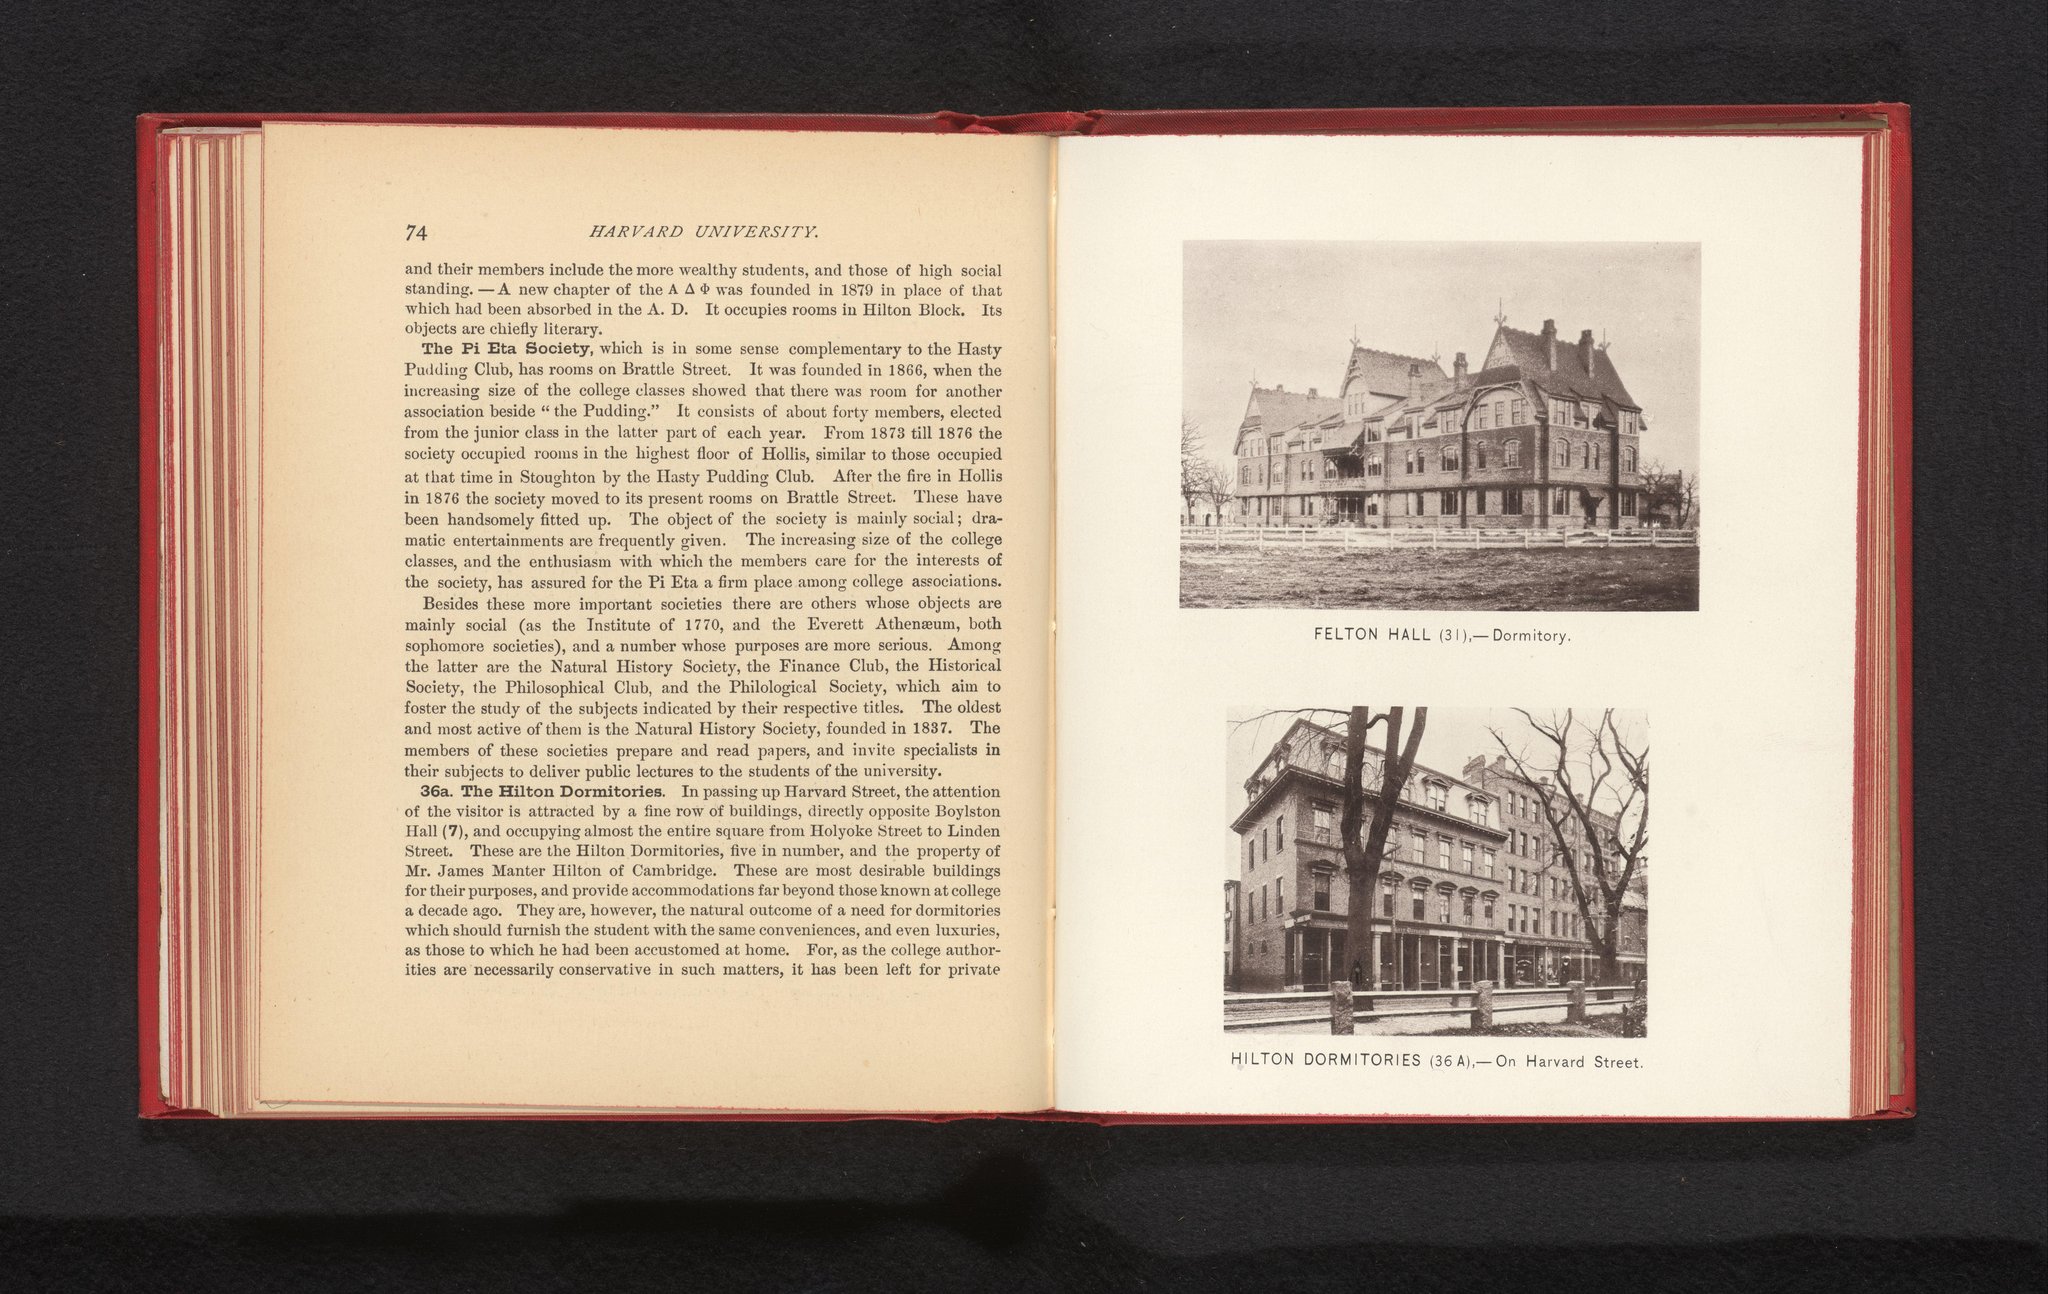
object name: photomechanical print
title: Felton Hall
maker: Anonymous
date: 1881-1886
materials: paper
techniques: photograph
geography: cambridge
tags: university building, college, façade (of house or building)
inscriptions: number: ‘(31) (36 A)’